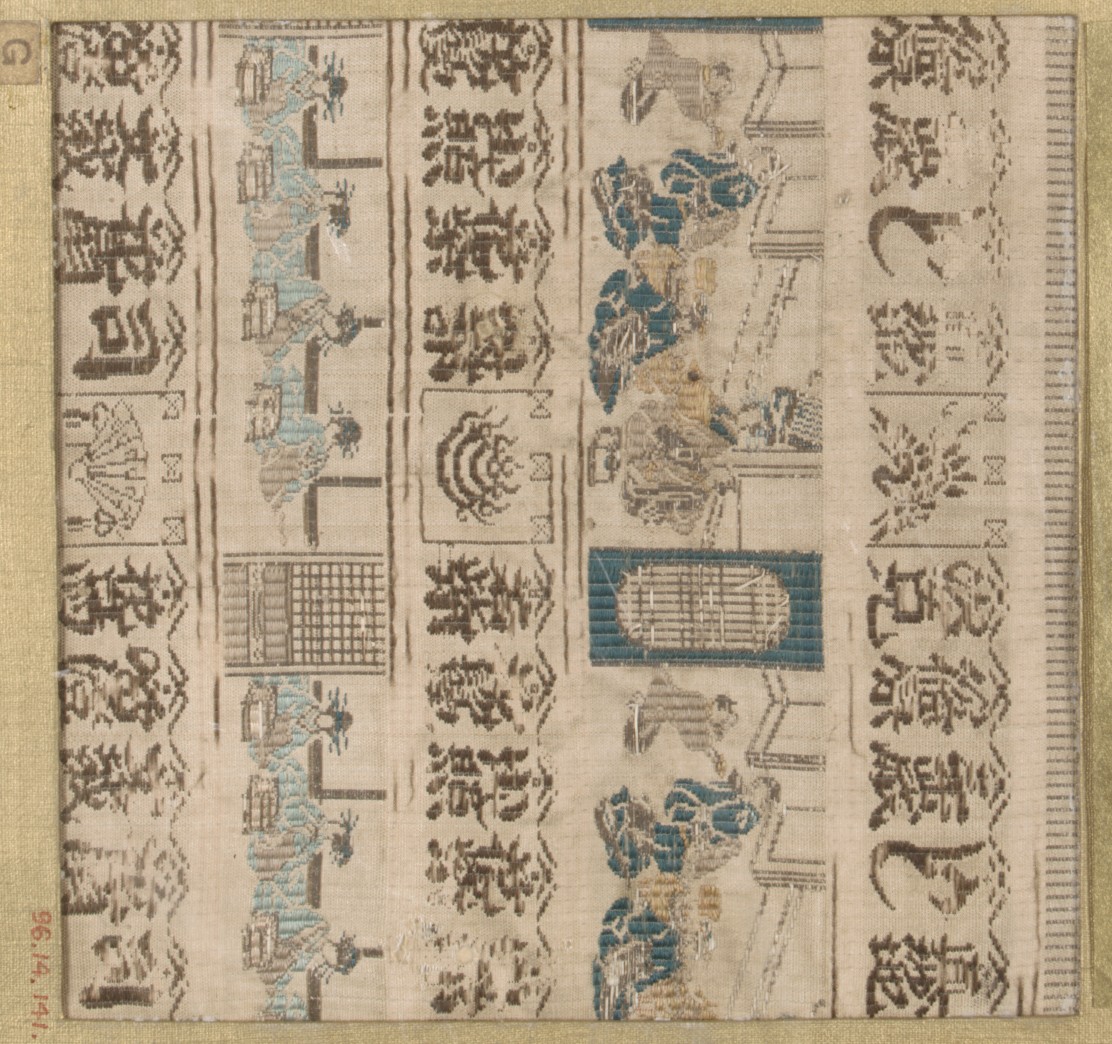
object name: piece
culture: japanese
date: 1701-1900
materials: silk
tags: human figures